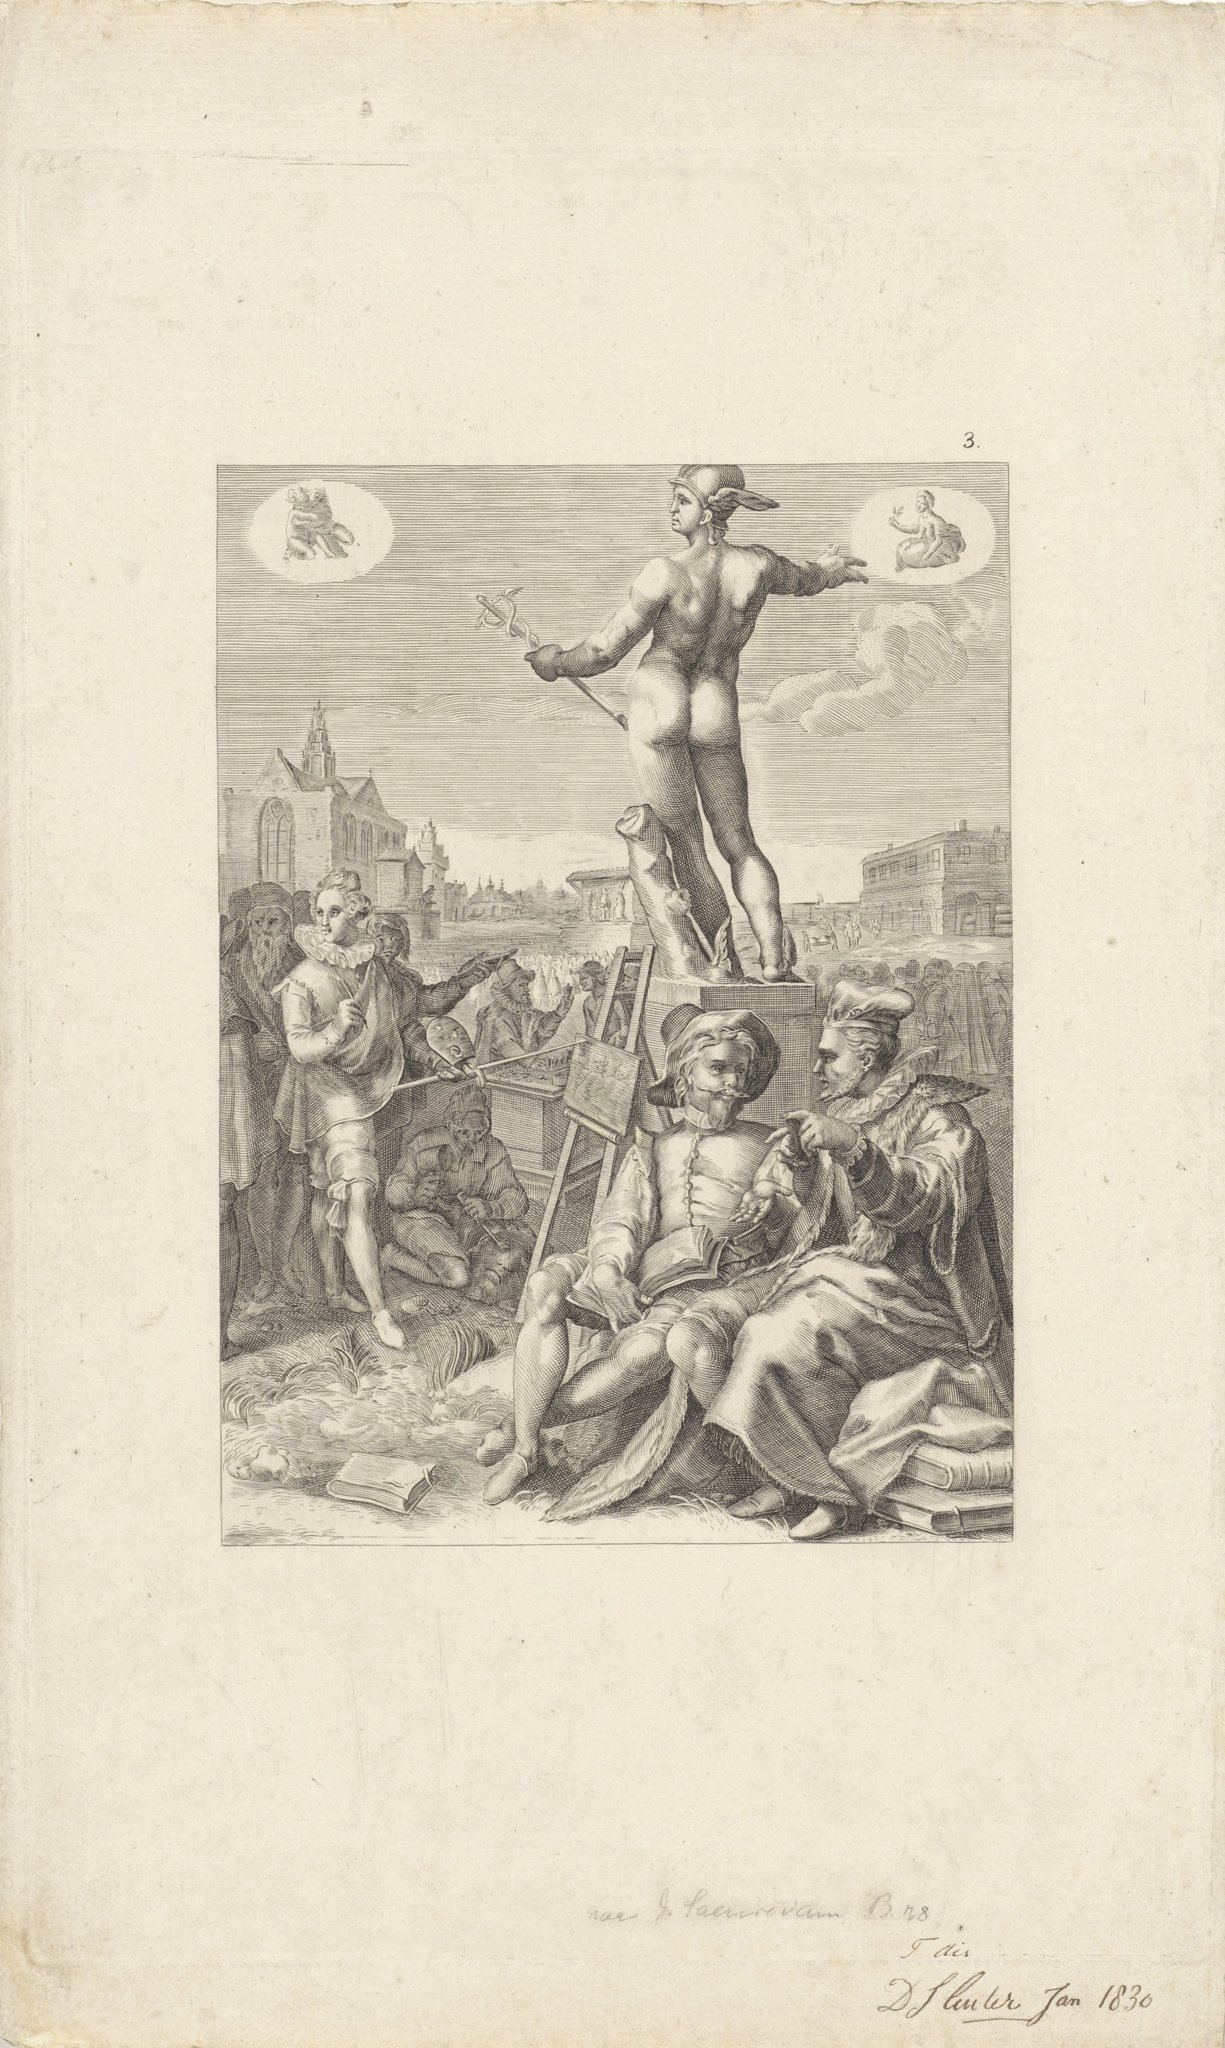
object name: print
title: Mercurius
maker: dirk jurriaan sluyter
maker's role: draughtsman, print maker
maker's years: 1811-1886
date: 1801-1830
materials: paper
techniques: engraving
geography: amsterdam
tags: artist (in general) (+ artist at work), (story of) mercury (hermes), debate, discussion (~ meeting) - aa - in the open air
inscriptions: inscription: ‘T dis. D. Sluiter Jan. 1830’, collector's mark: Lugt 2228, inscription: ‘Naar J. Saenredam B. 78’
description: Te midden van verschillende kunstenaars staat de naakte Mercurius als heerser over de kunsten op een sokkel. Op de voorgrond voeren twee schrijvers een discussie. In de lucht symbolen van de sterrenbeelden tweelingen (links) en maagd (rechts).